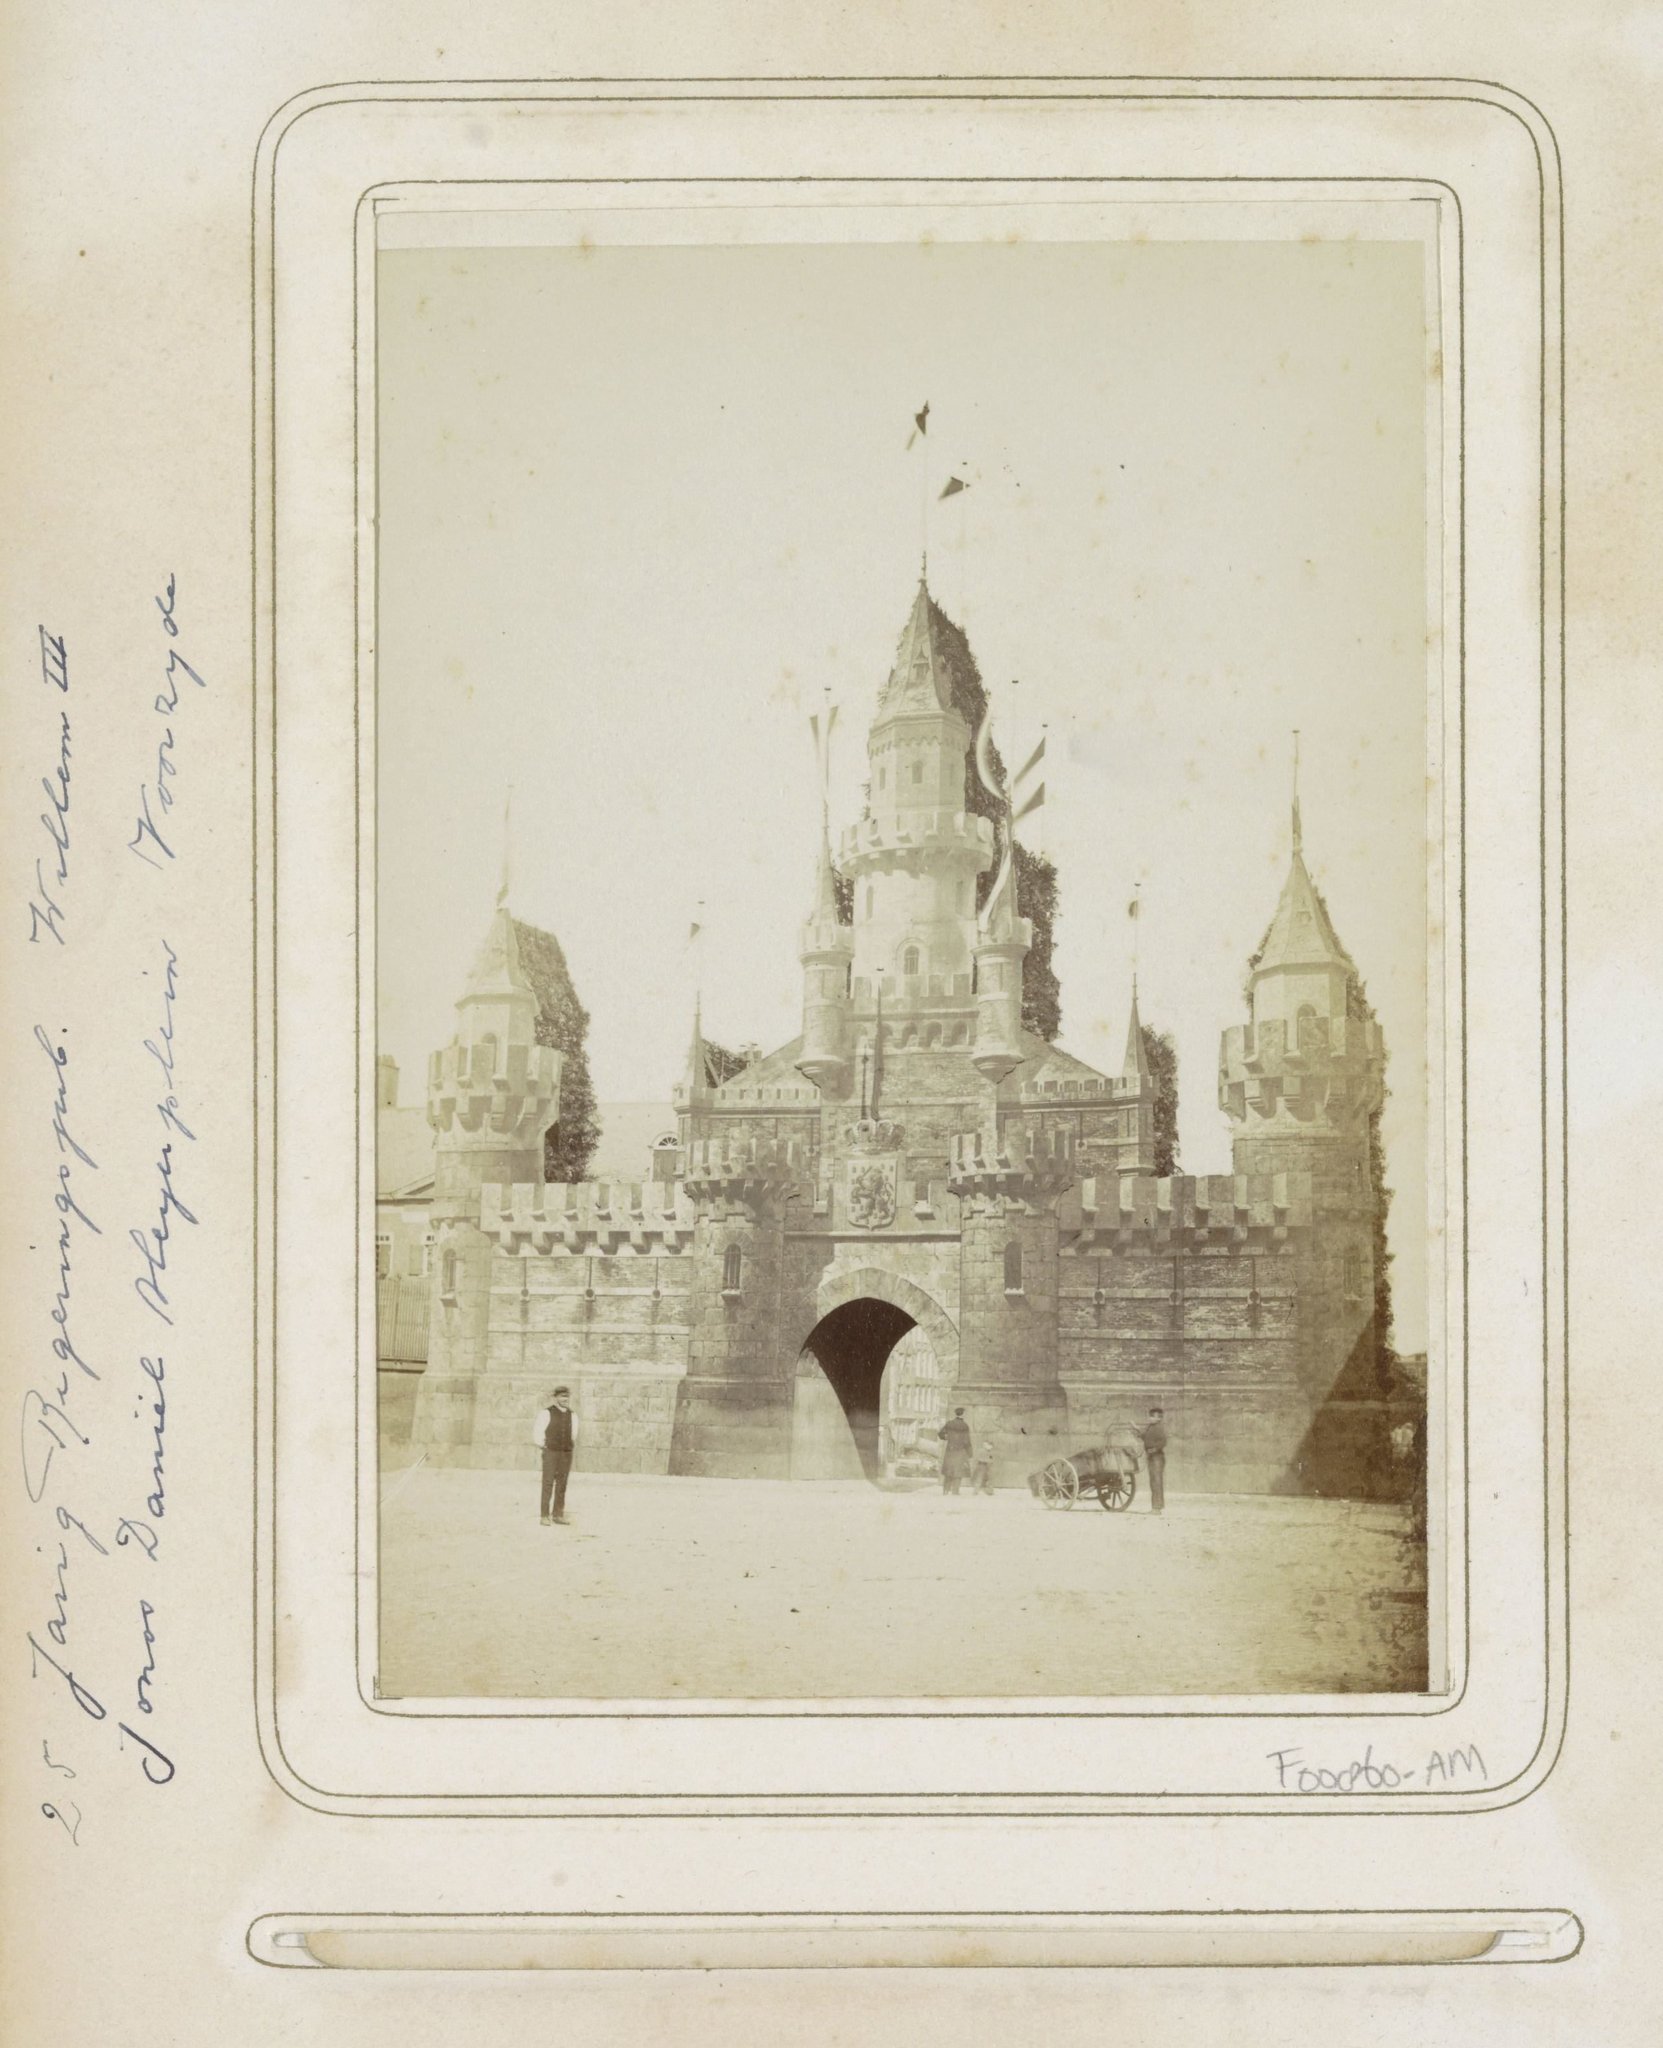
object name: cabinet photograph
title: Poortgebouw (voorzijde) op het Jonas Daniël Meijerplein, opgericht ter gelegenheid van het 25-jarig regeringsjubileum van koning Willem III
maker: Anonymous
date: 1874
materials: cardboard, paper, photographic support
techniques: albumen print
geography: amsterdam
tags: public festivities on the occasion of royal events, commemoration, jubilee (+ the public ~ festive activities), city-gate, prospect of city, town panorama, silhouette of city, amsterdam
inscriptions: inscription: ‘Amsterdam Jonas D. Meyerplein voorzijde 25 jarig regeeringsjubileüm Willem III’